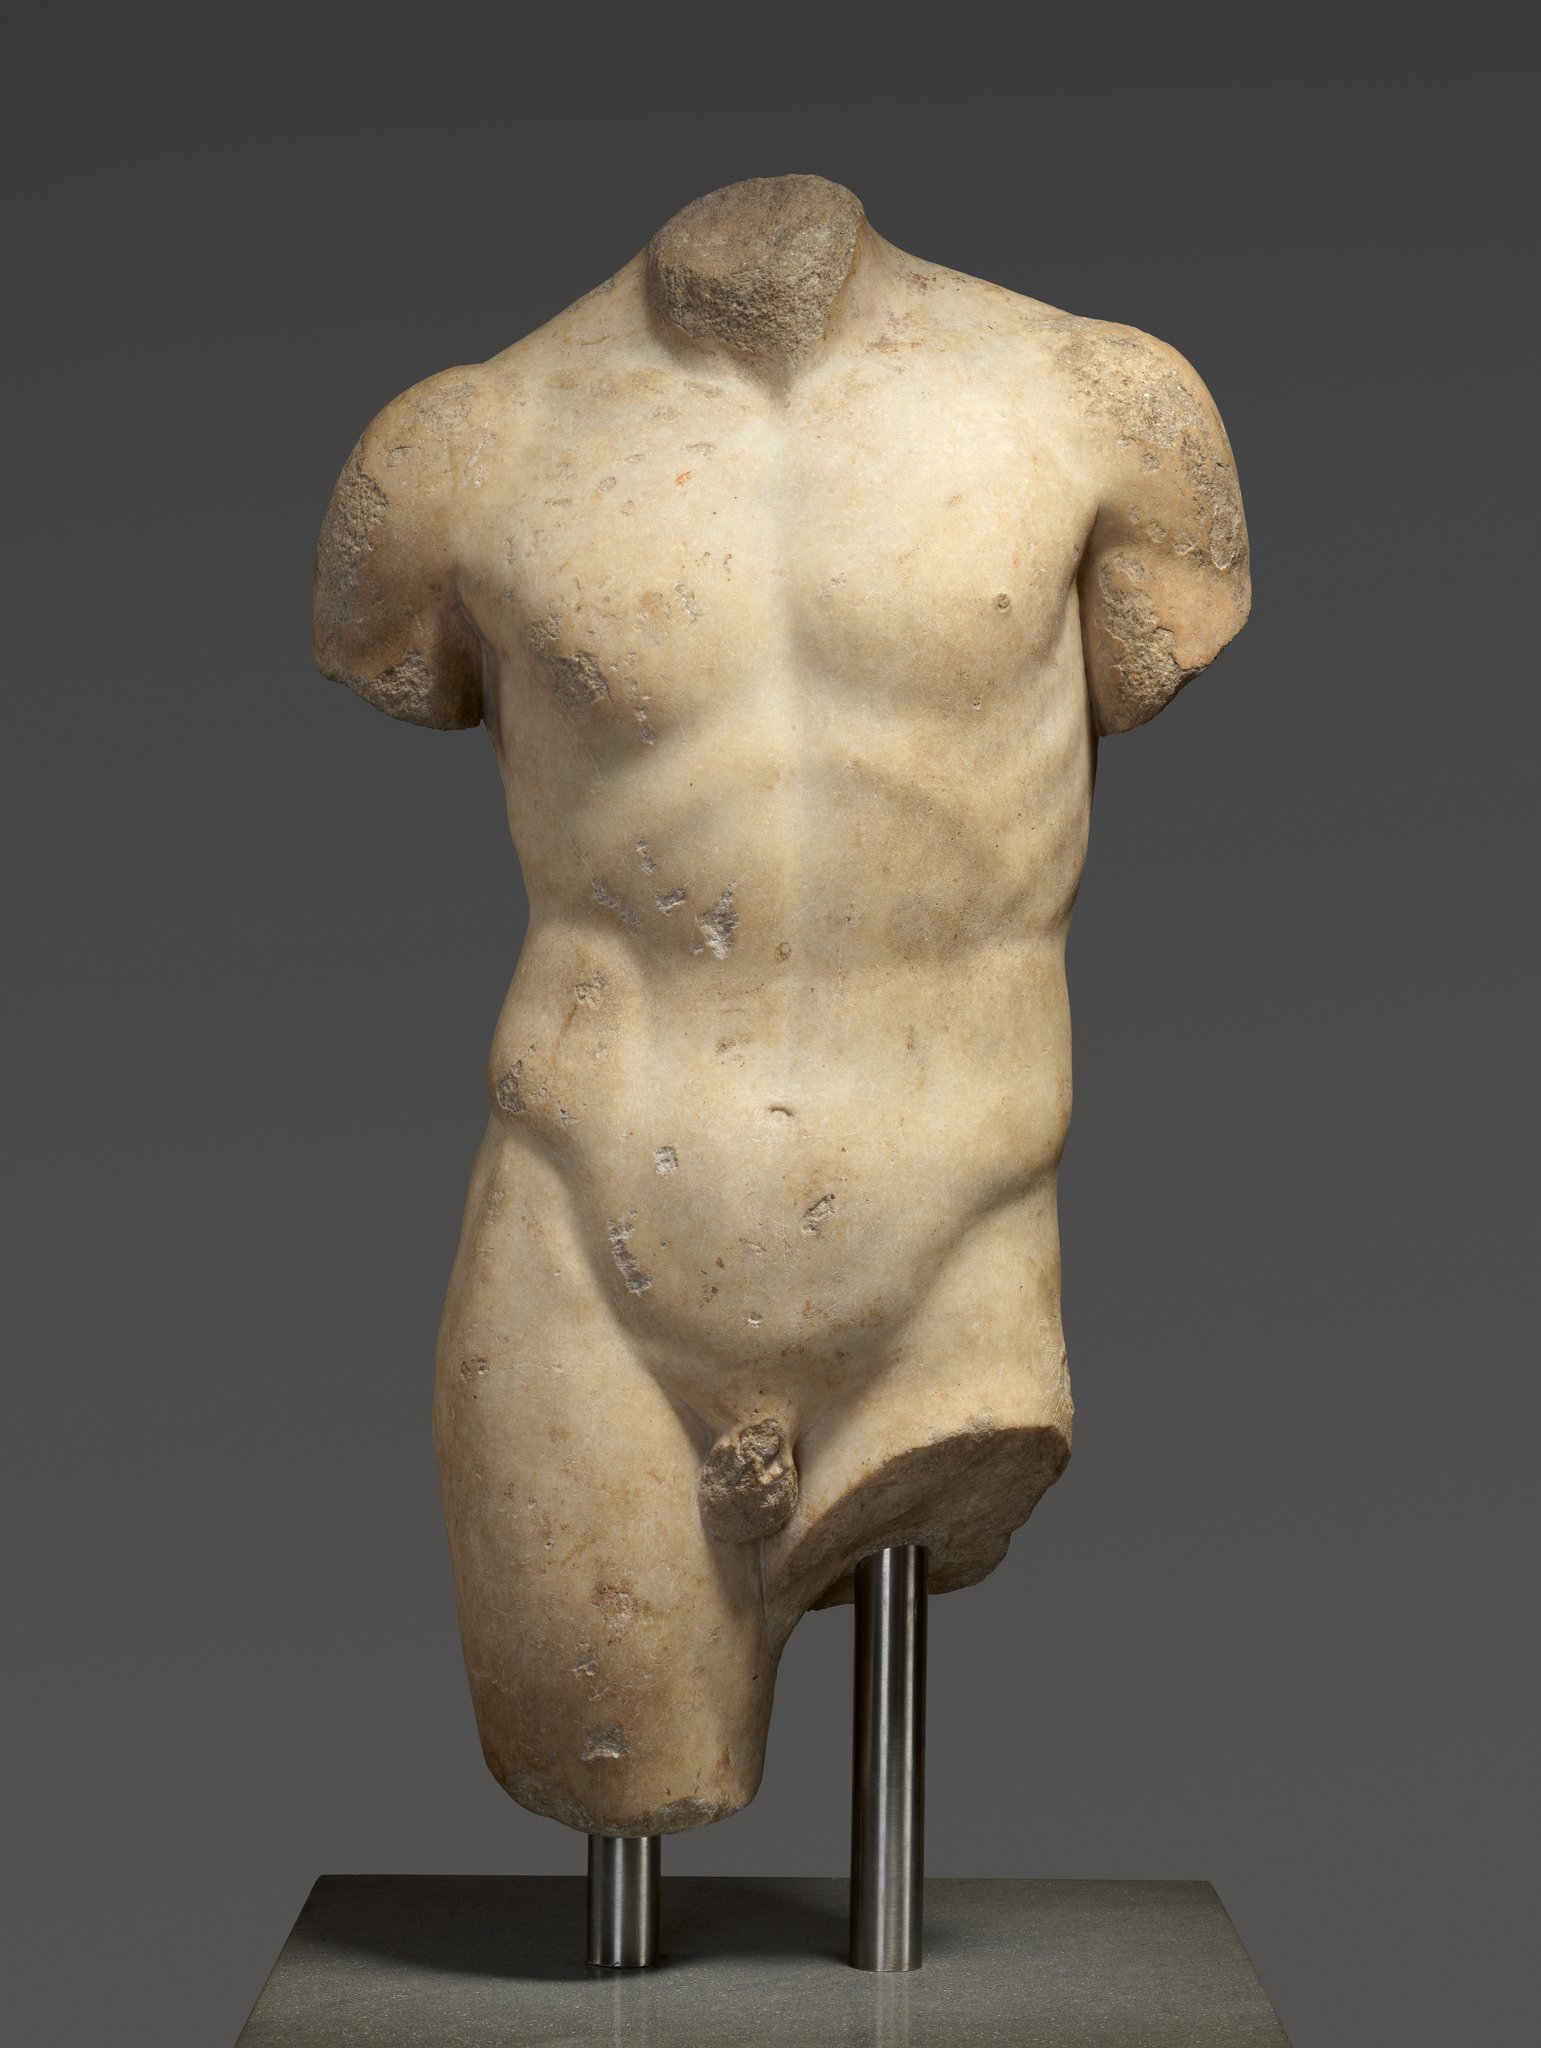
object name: statue of a youth, torso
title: Marble torso of a youth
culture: roman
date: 118-161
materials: marble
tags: male nudes